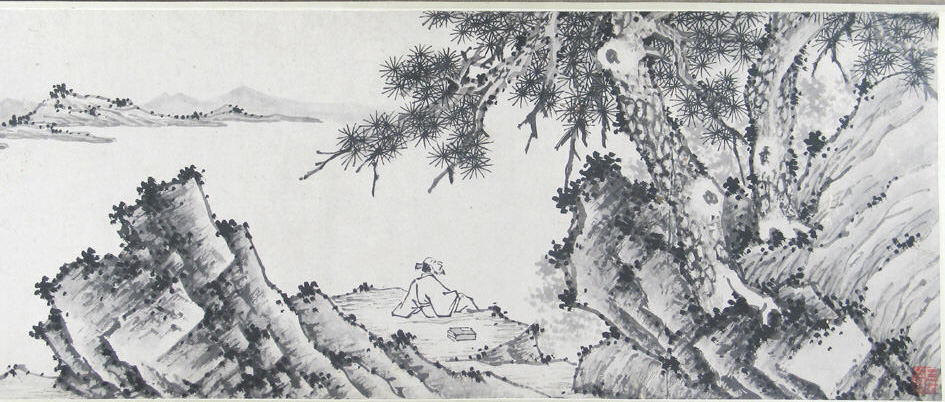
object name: handscroll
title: Enjoying the Pines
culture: chinese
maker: shen zhou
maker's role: artist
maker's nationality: chinese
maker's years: 1427-1509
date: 1368-1644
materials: gold, ink, paper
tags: men,landscapes